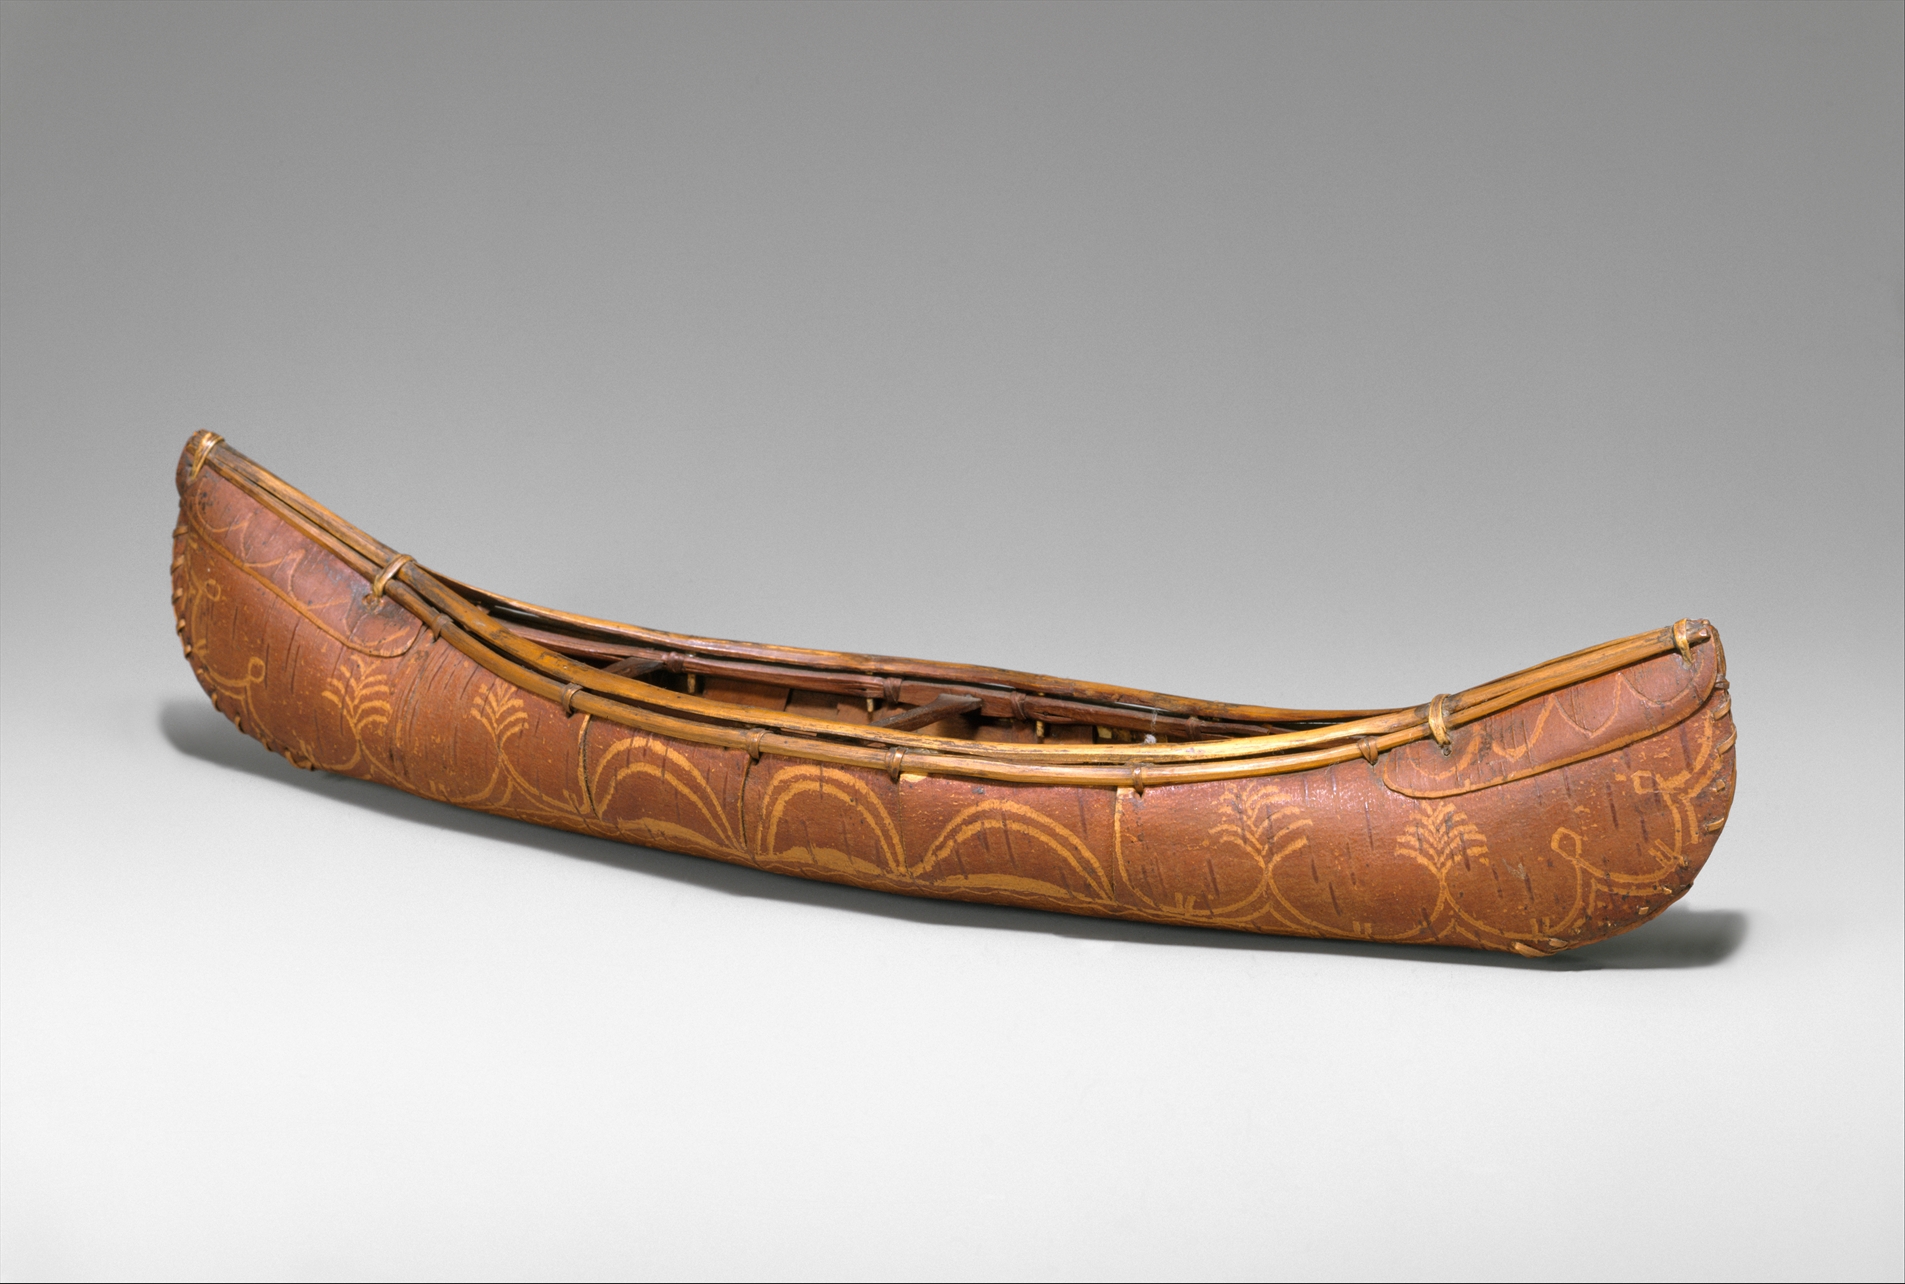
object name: canoe model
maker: jo polis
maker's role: artist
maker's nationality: native american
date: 1875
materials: wood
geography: united states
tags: boats